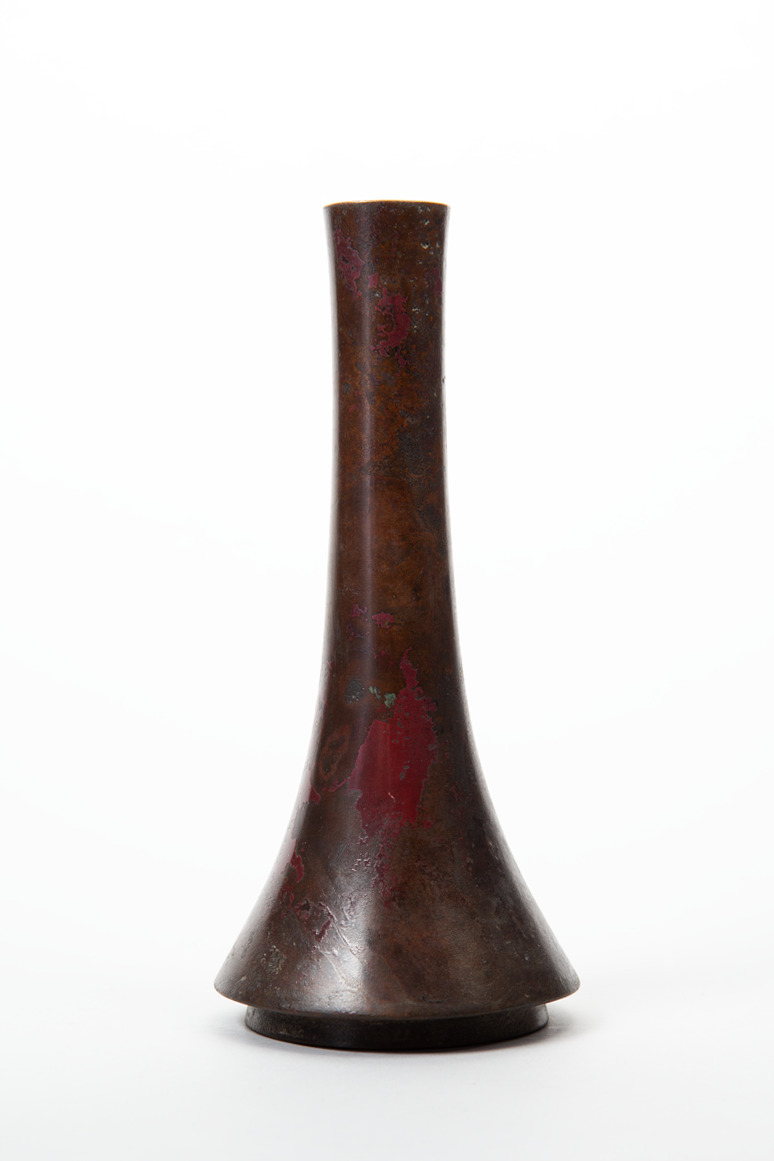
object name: vase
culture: japanese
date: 1801-1833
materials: bronze